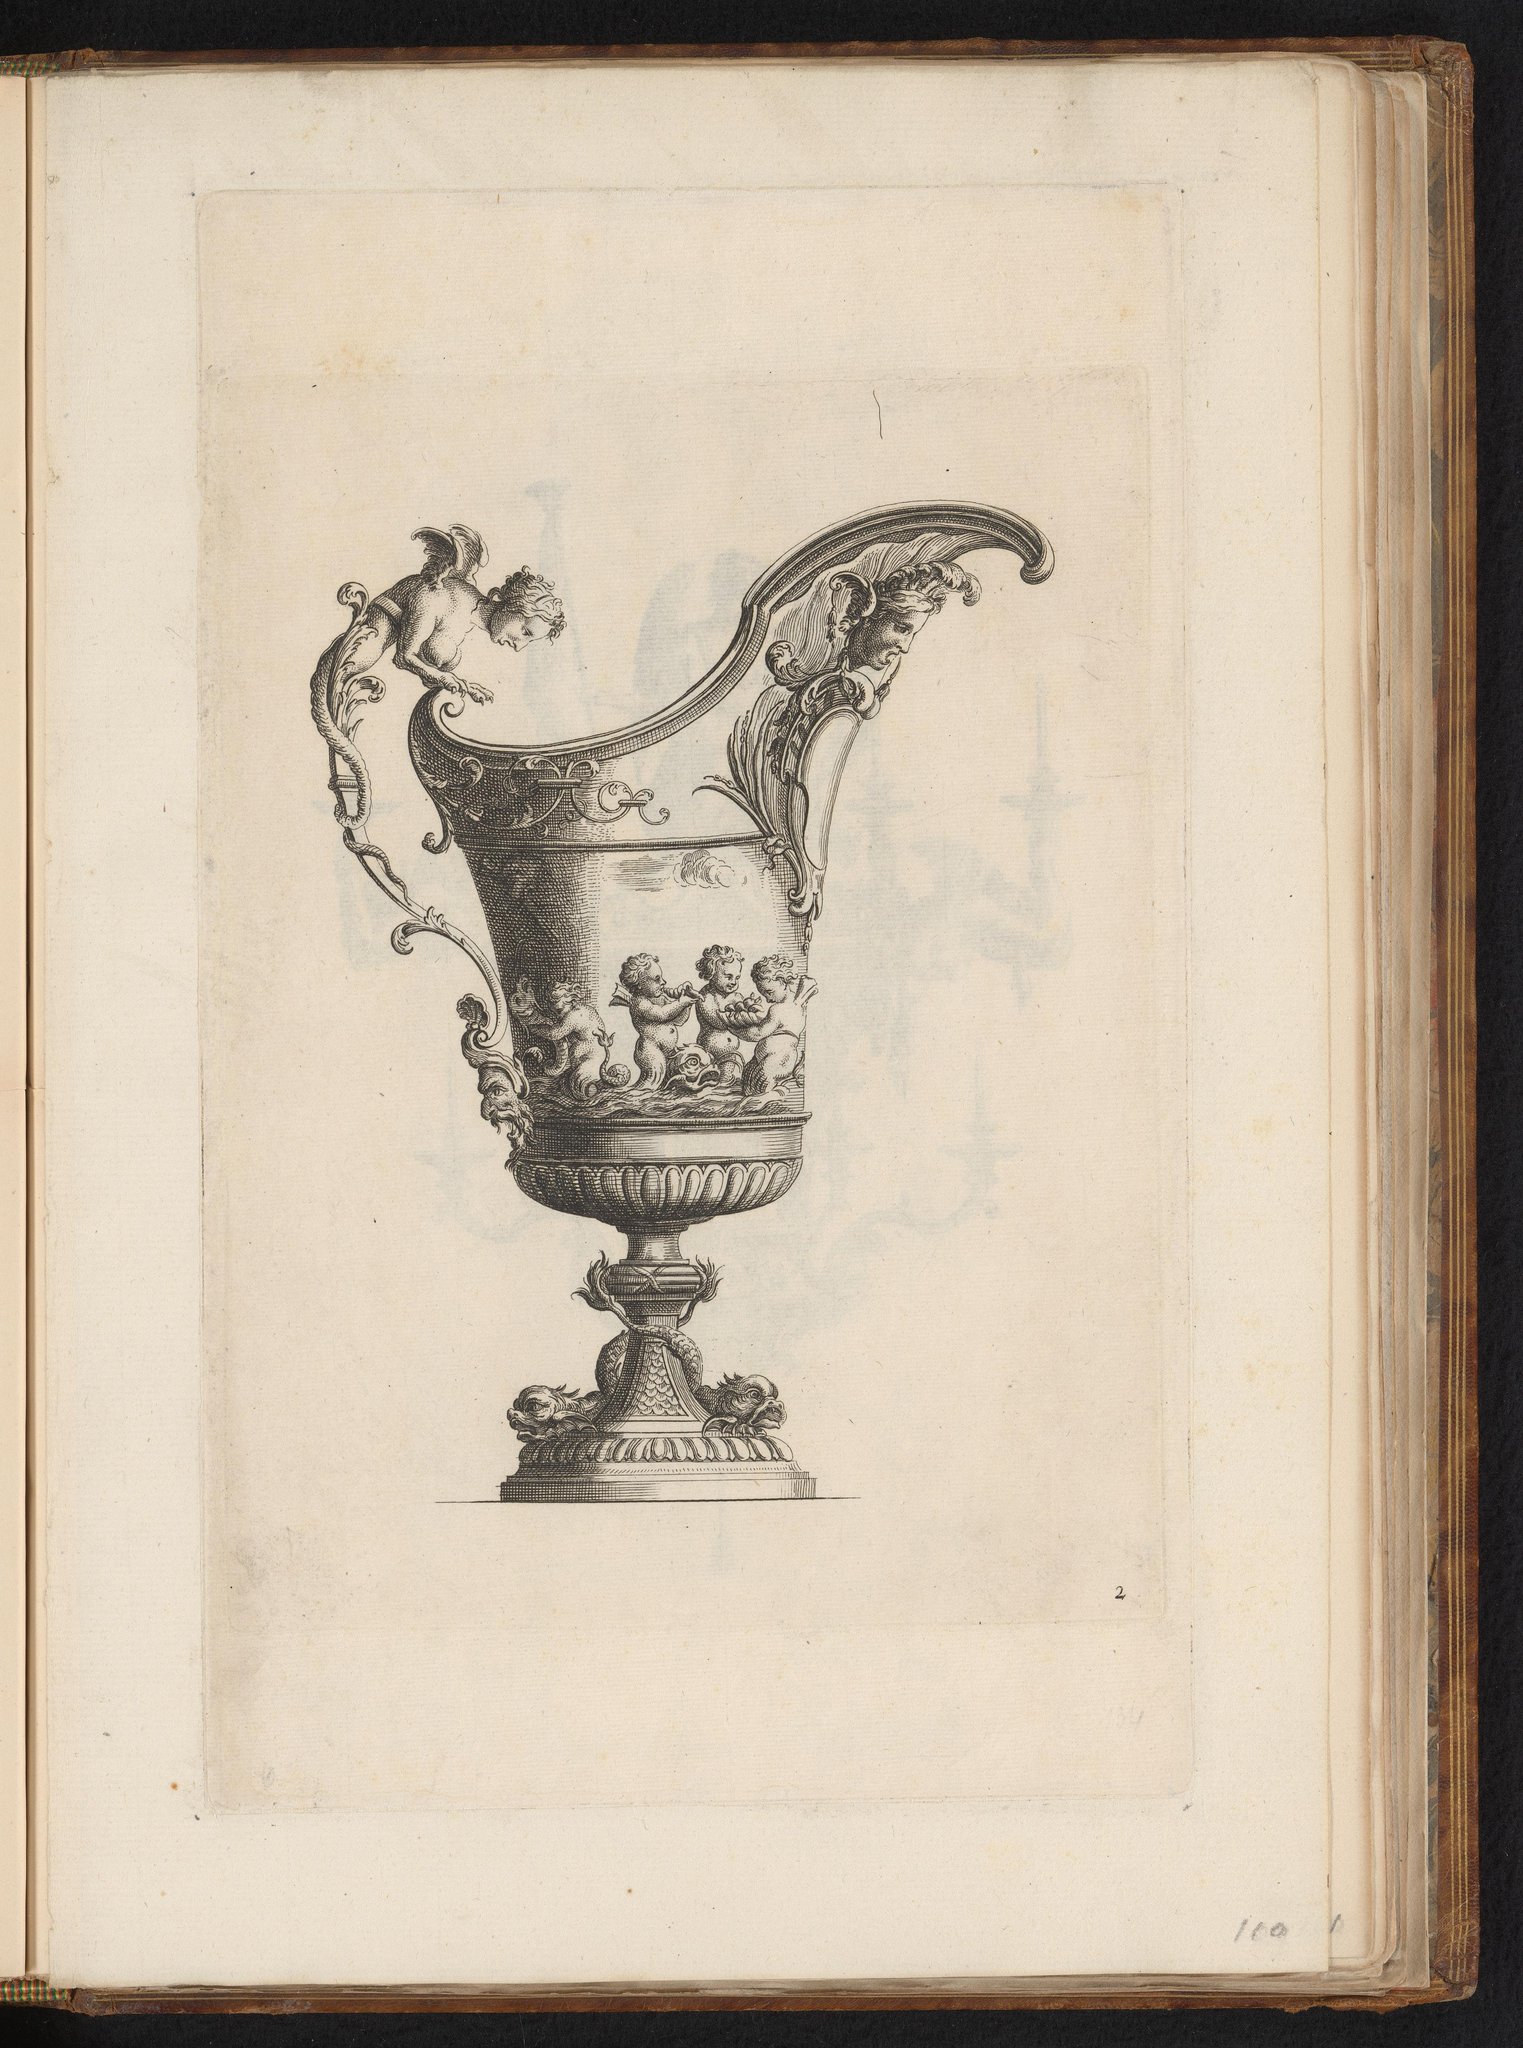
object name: ornament print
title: Livre pour Vaisselle d'Eglise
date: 1700-1735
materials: paper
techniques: etching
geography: nuremberg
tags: dolphin ~ ornament, gods of the waters: the older dynasty (first series): offspring of pontus and the monsters of the sea, monsters ~ fishes, cupids: 'amores', 'amoretti', 'putti'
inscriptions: collector's mark: Lugt 2228, collector's mark: Lugt 2760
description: Kopie in spiegelbeeld naar de serie "Livre pour Vaisselle d'Eglise" uitgegeven door Balthazar Pavillon.